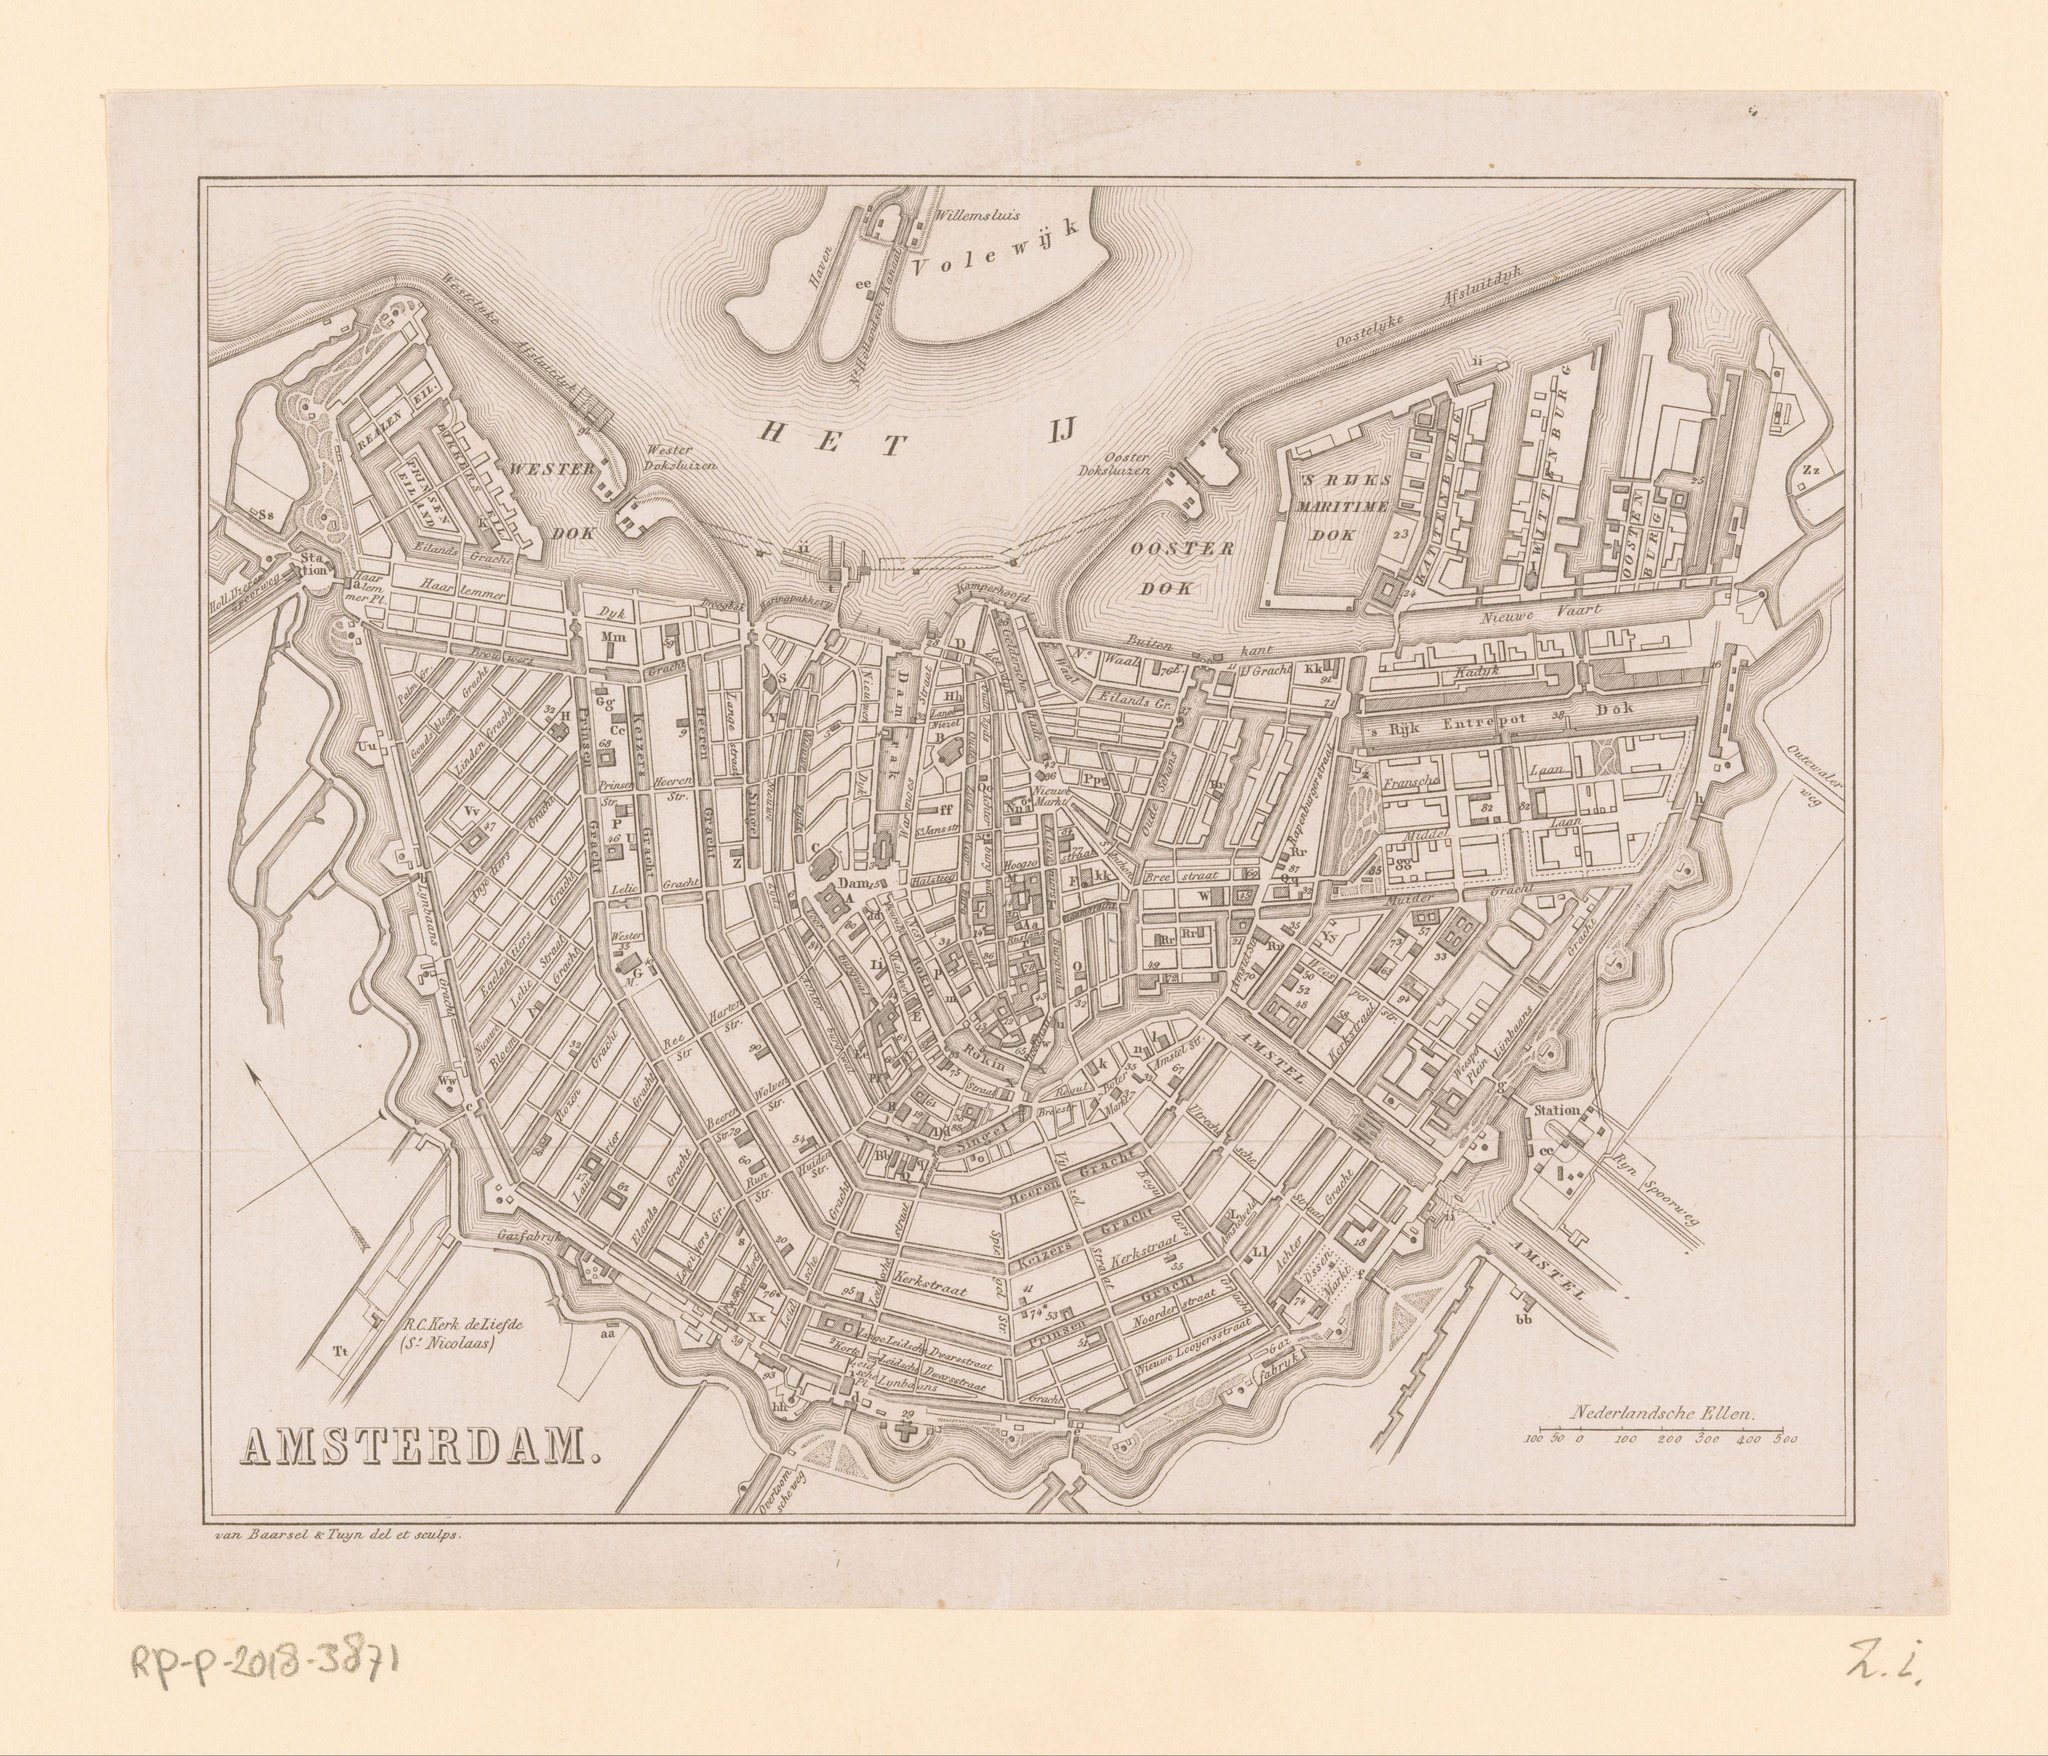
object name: area plan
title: Plattegrond van Amsterdam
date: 1843-1854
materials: paper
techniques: etching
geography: amsterdam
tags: maps of cities, amsterdam